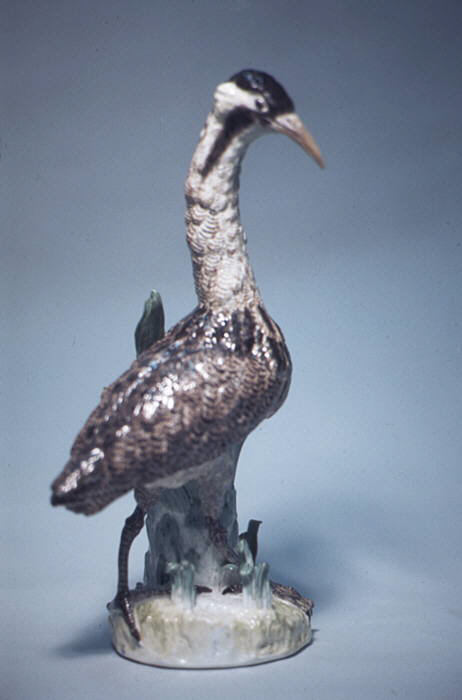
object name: figure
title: Bittern (one of a pair)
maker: meissen manufactory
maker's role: manufactory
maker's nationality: german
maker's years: 1710-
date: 1750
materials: hard paste porcelain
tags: birds